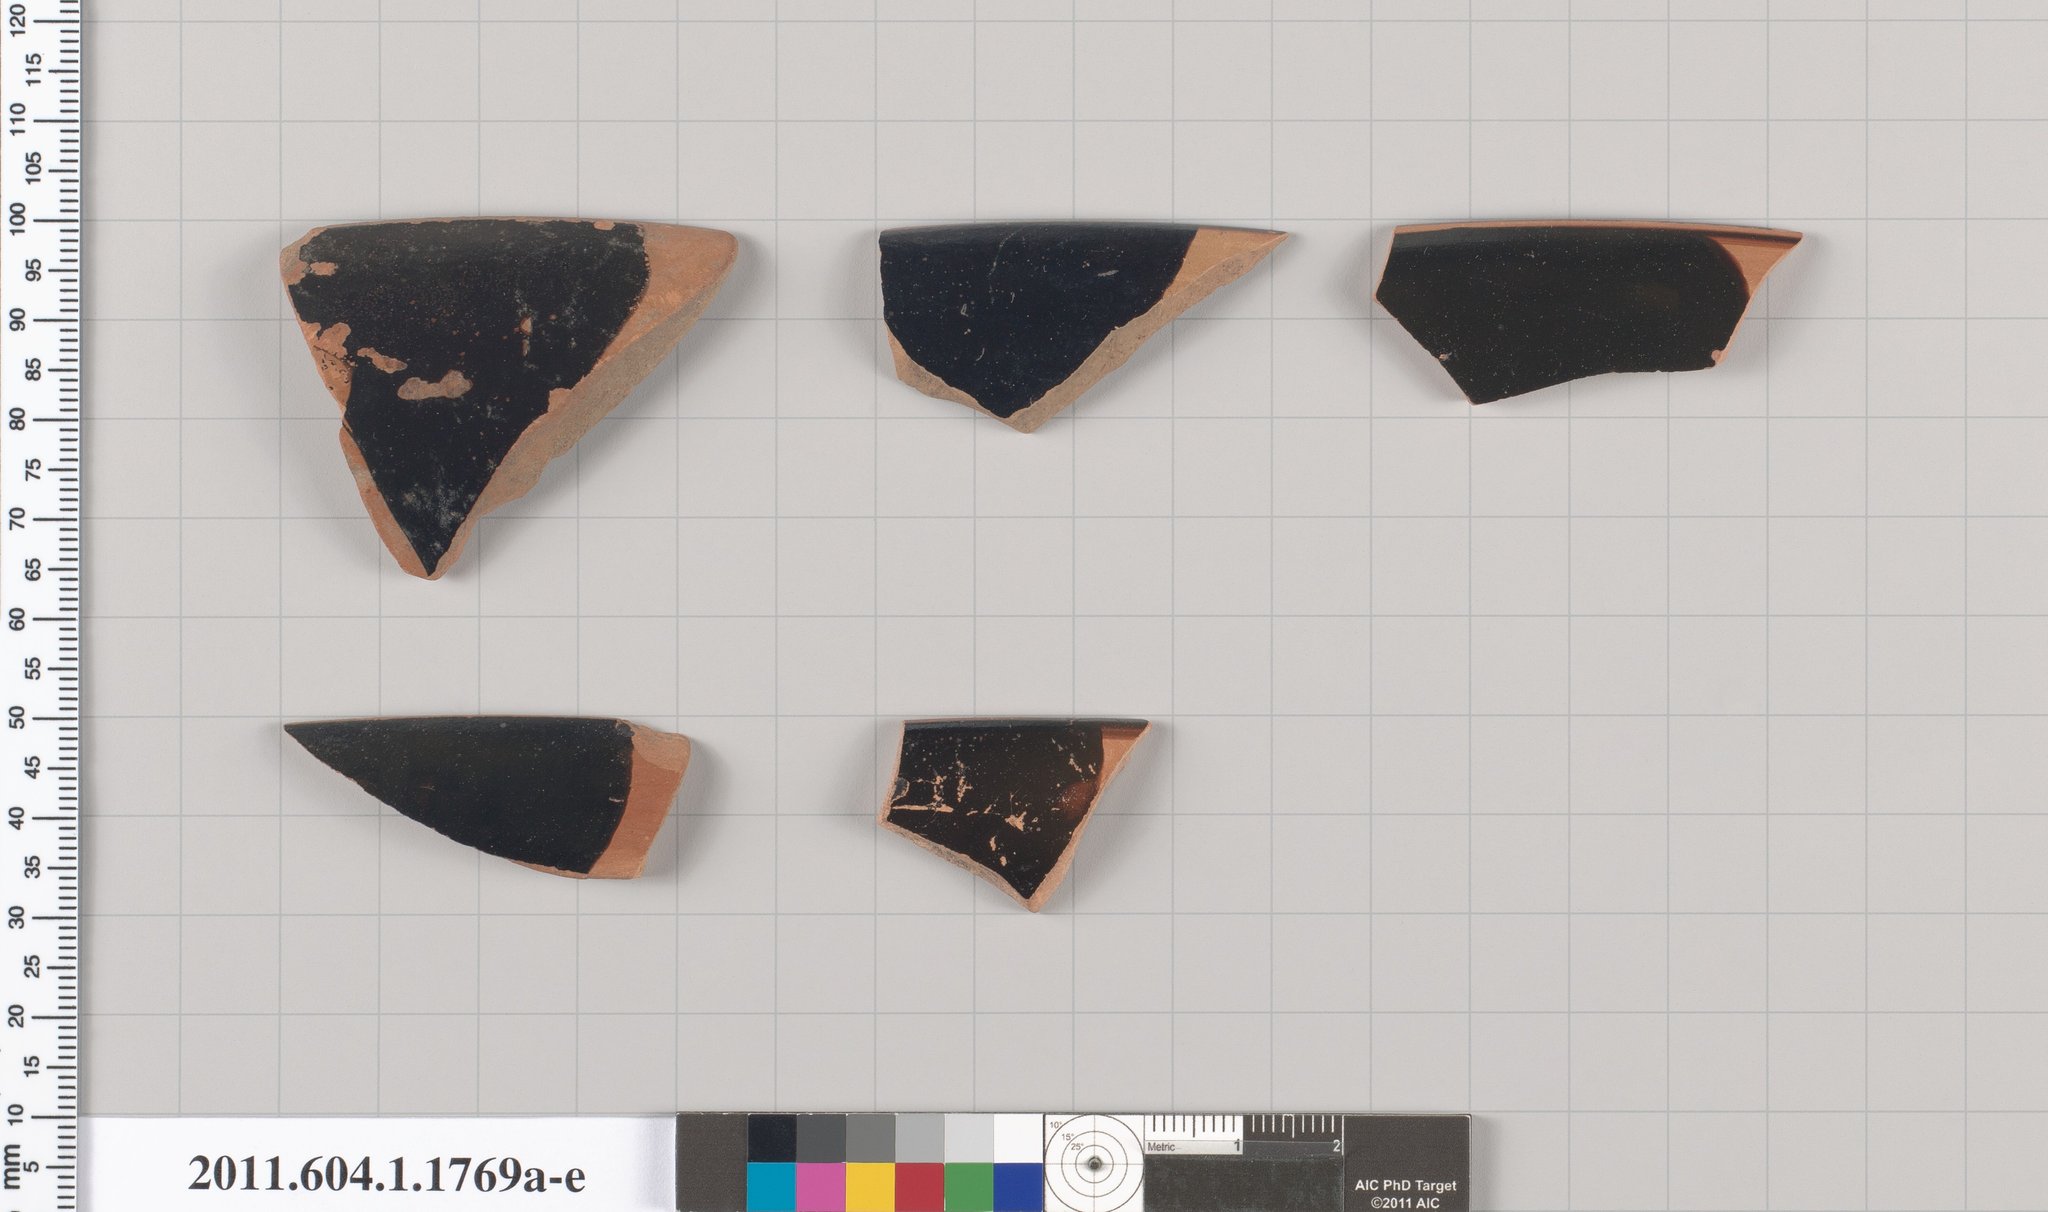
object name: kylix fragment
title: Terracotta rim fragments of kylikes(drinking cups)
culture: greek, attic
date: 500-401 BCE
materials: terracotta